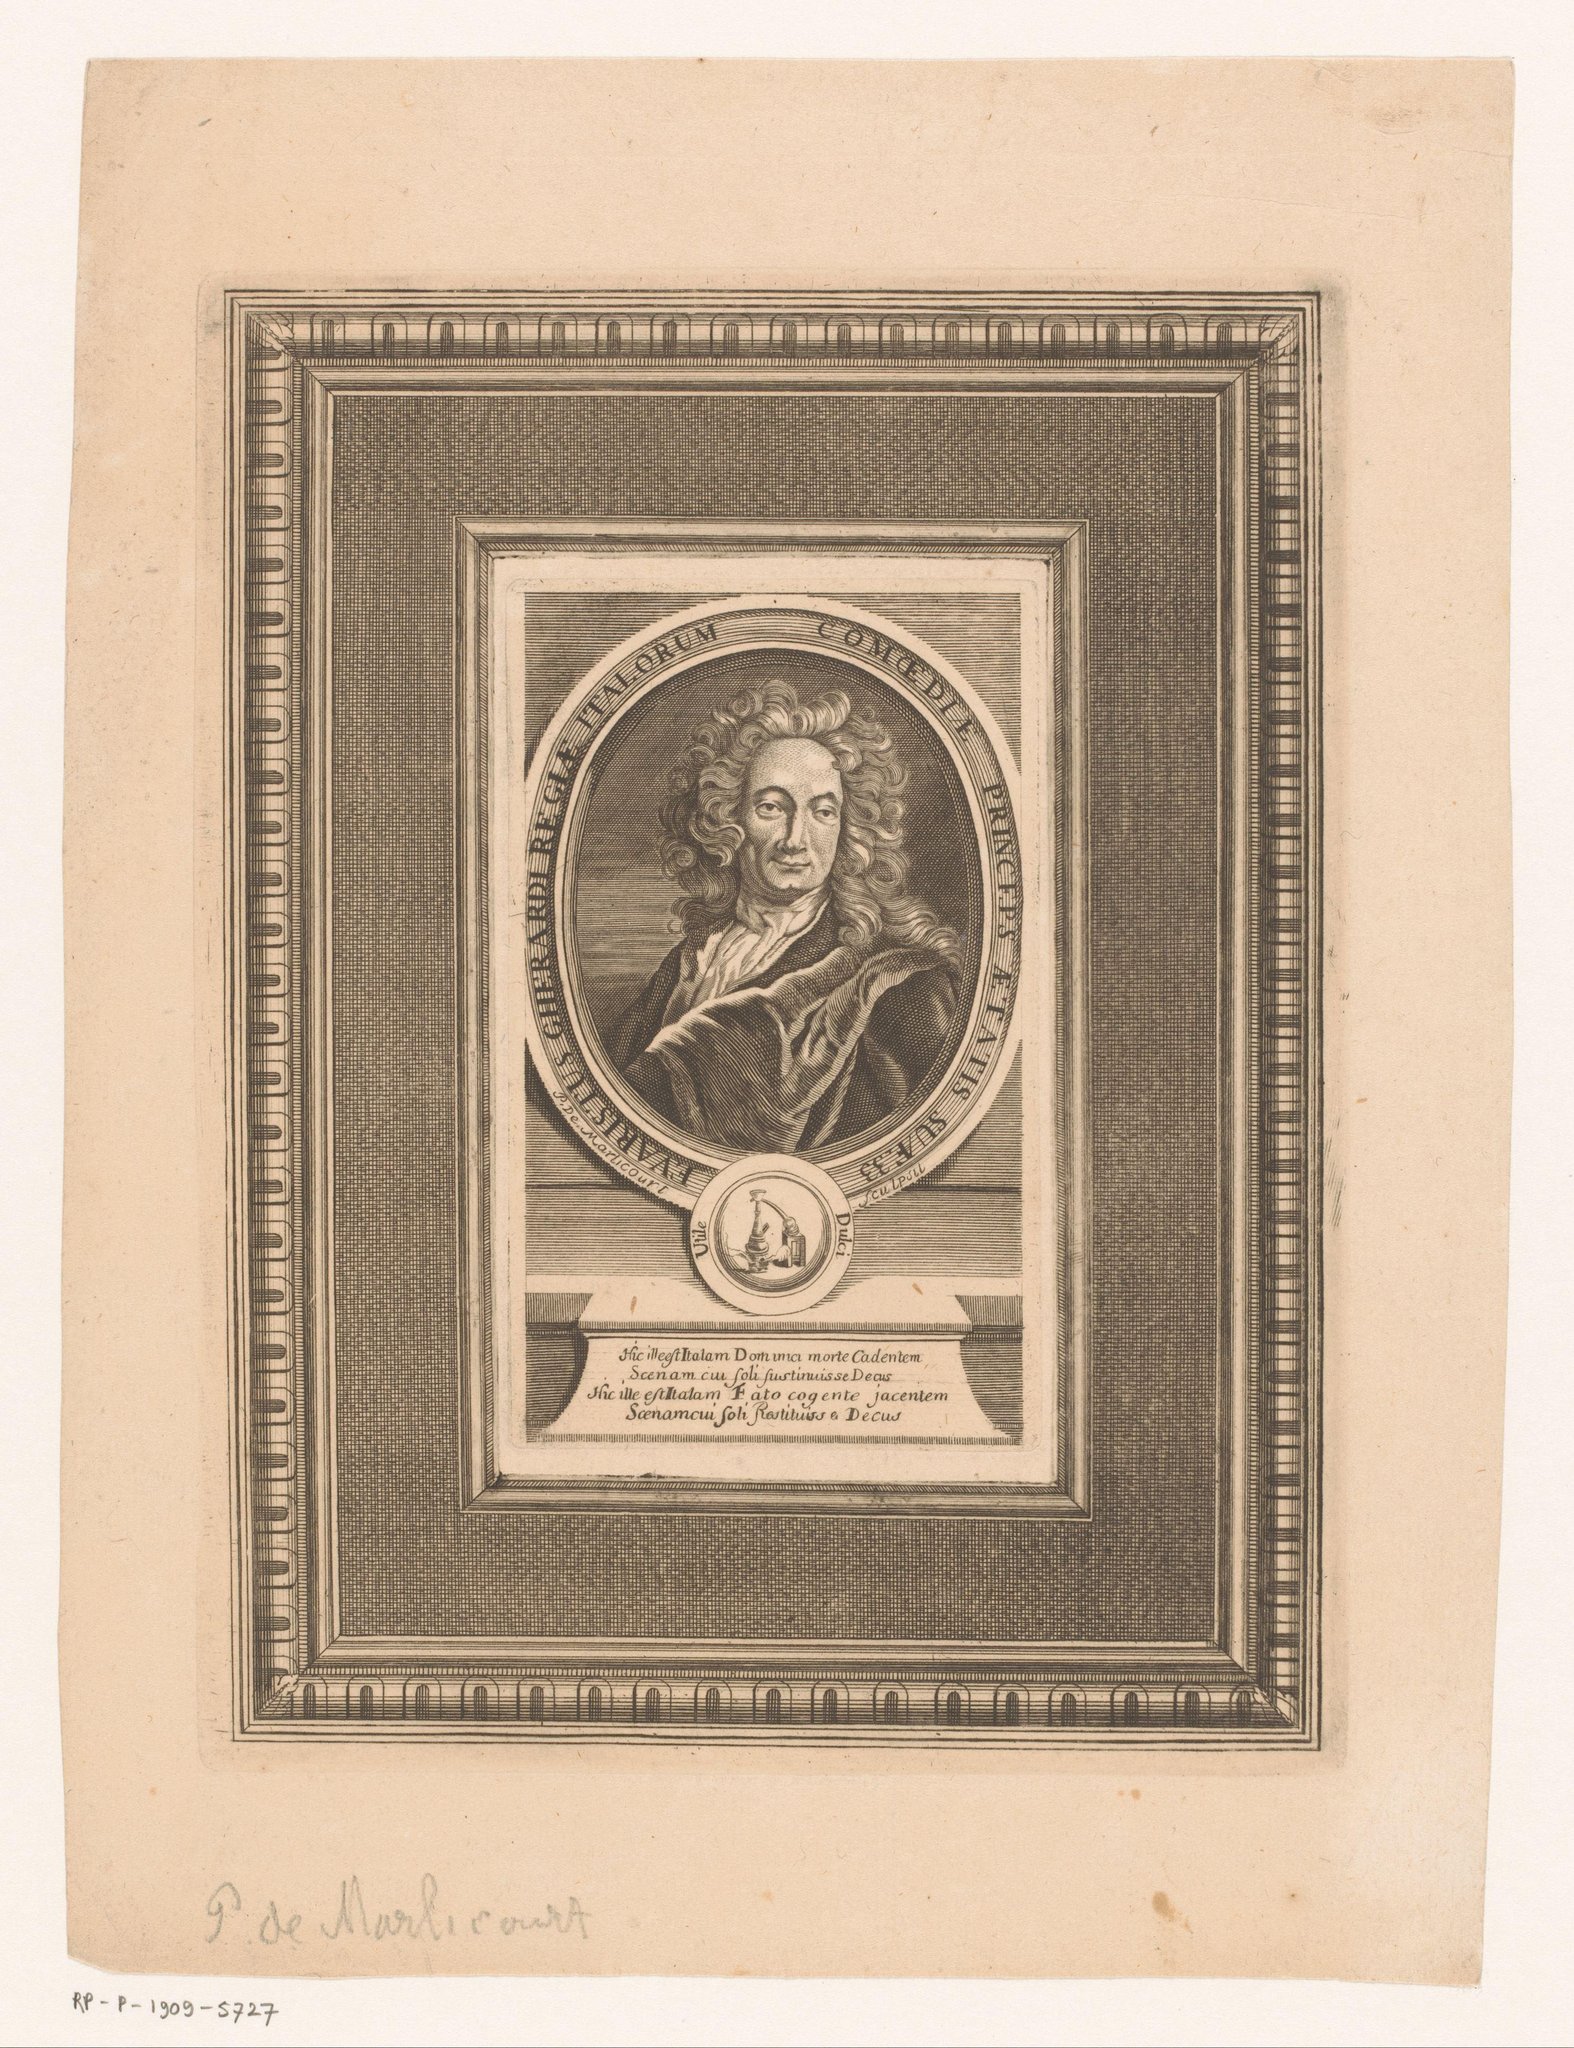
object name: print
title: Portret van Fauristus Gherardi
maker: p. de marlicourt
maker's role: print maker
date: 1600-1730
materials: paper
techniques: engraving, etching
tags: historical persons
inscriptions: collector's mark: Lugt 2228